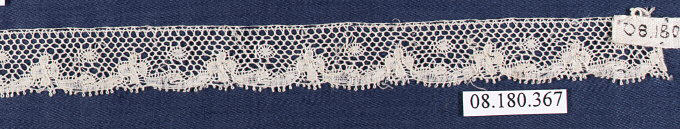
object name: piece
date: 1701-1800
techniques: lace